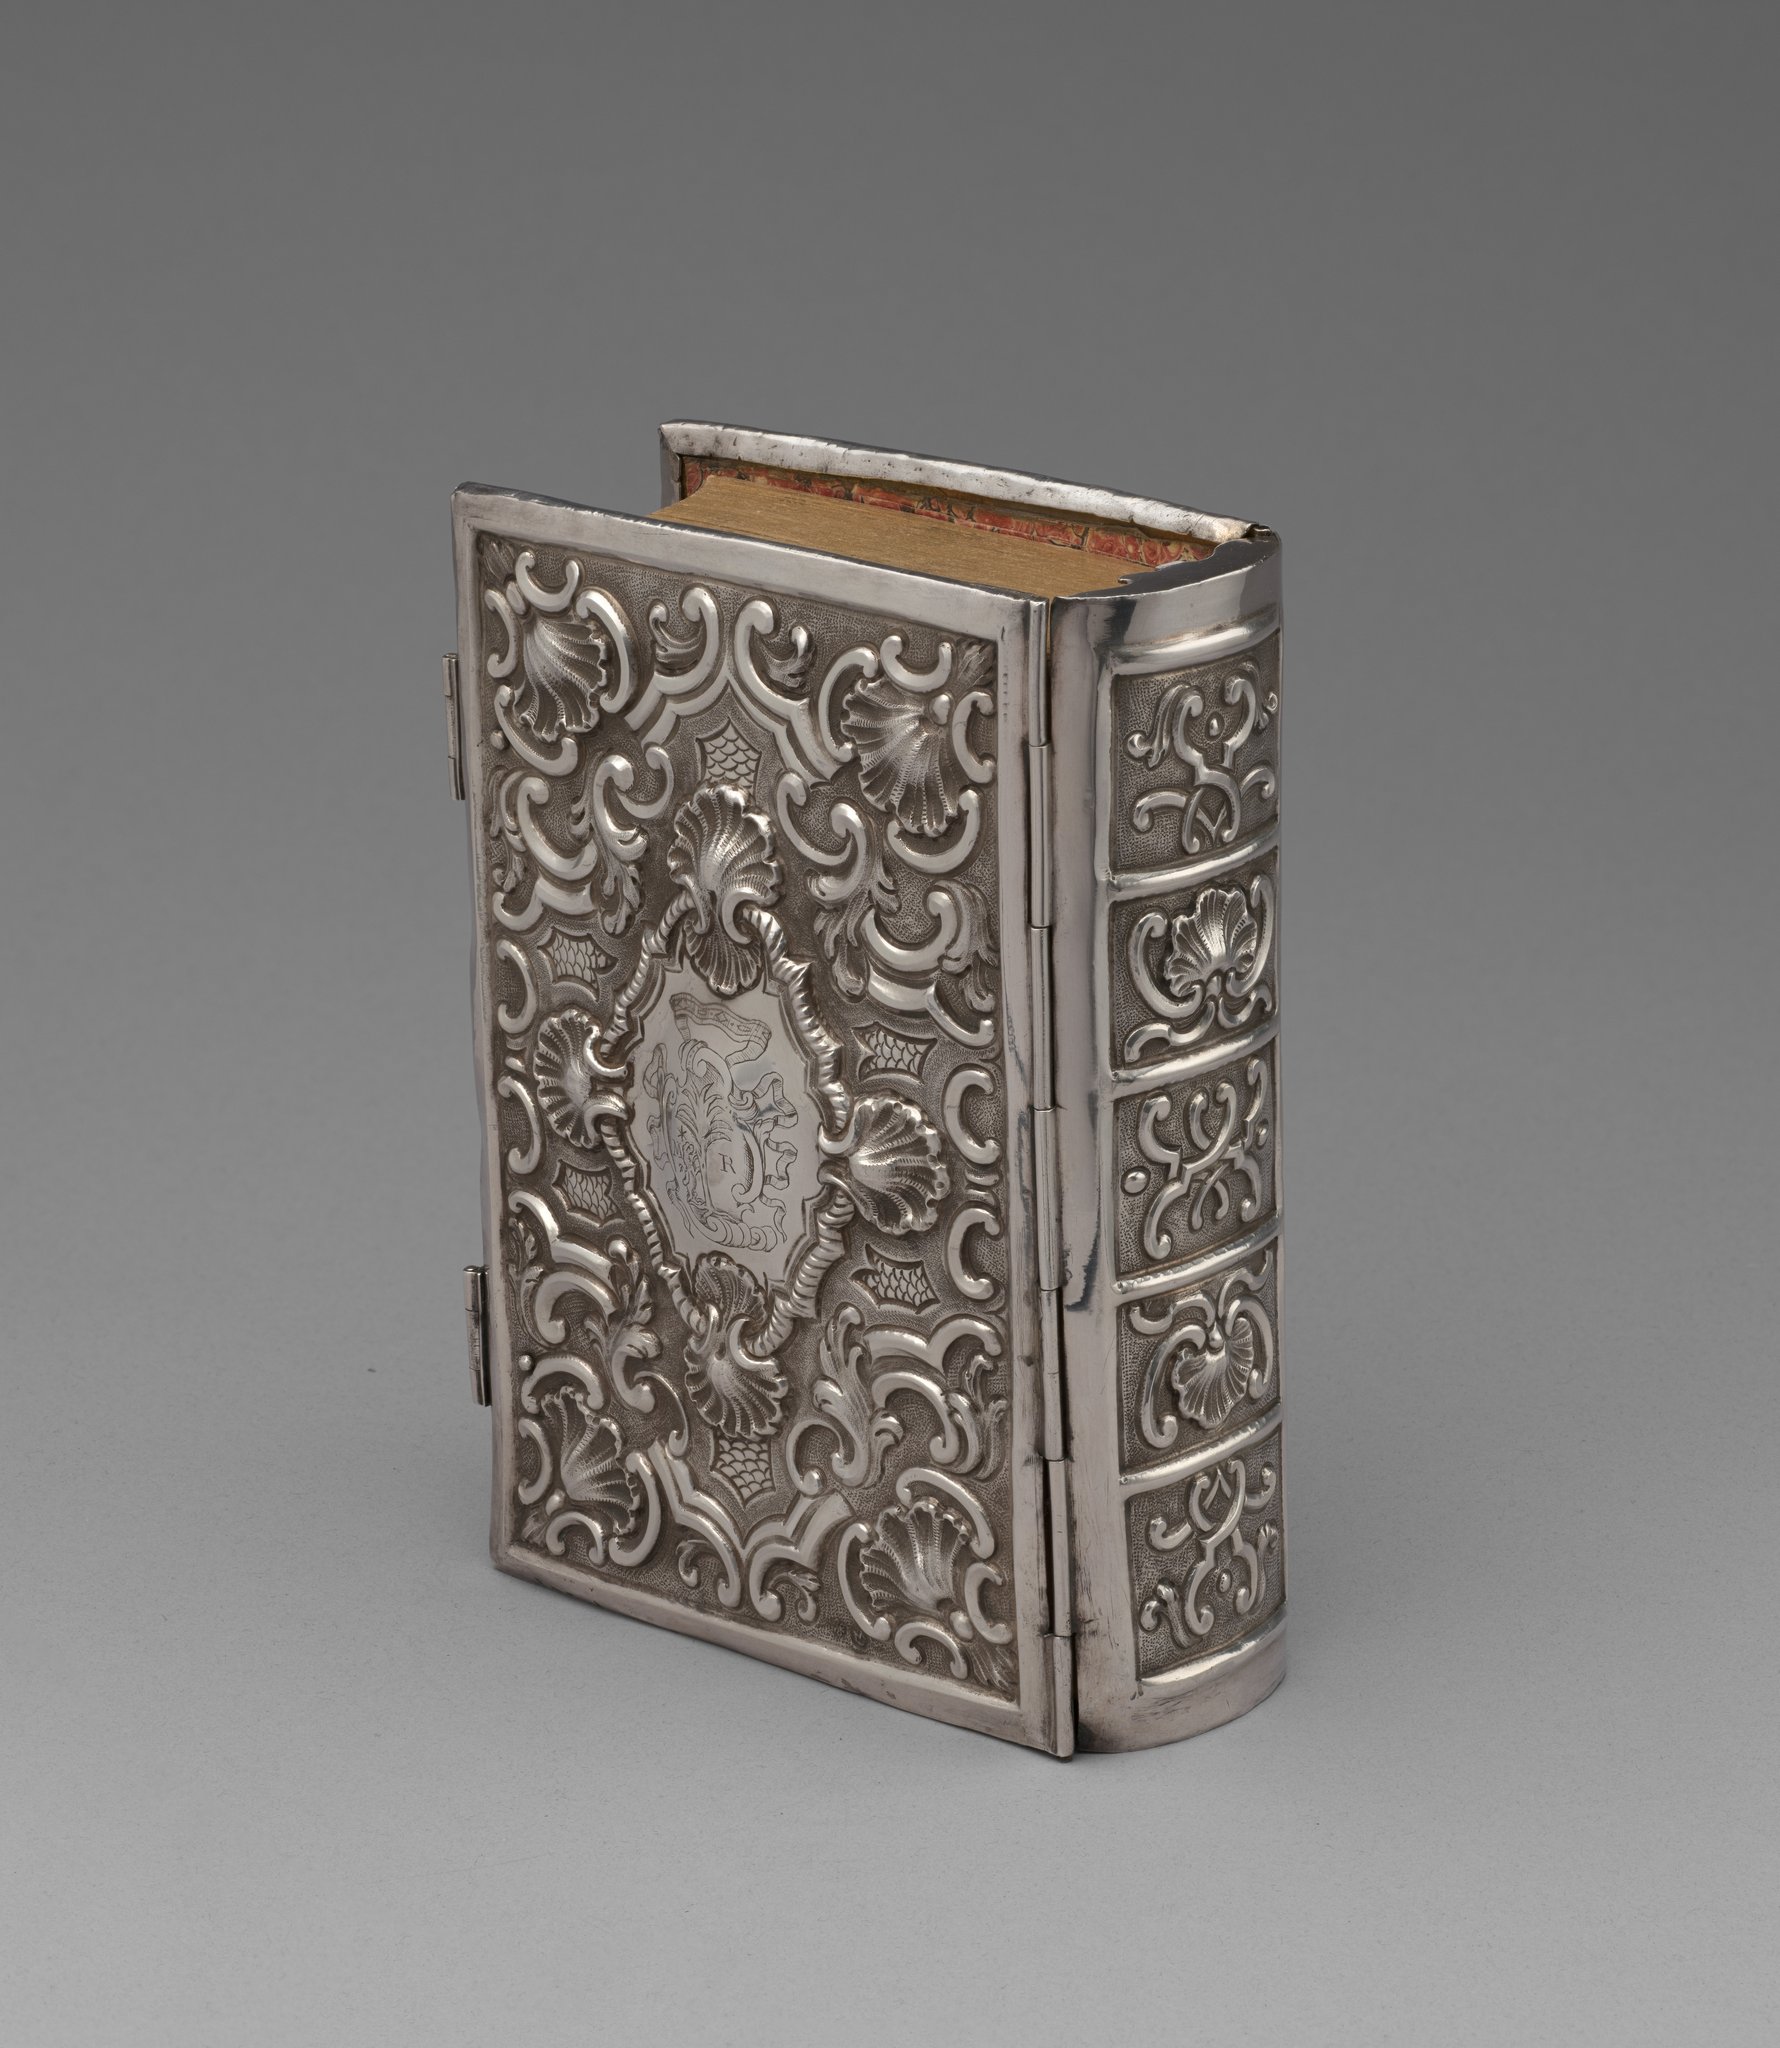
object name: book cover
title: Book cover for Mahzor prayer book with leather case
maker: giuseppe merlini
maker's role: maker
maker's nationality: italian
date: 1755-1757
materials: leather, paper, silver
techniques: chasing, embossing, gilding